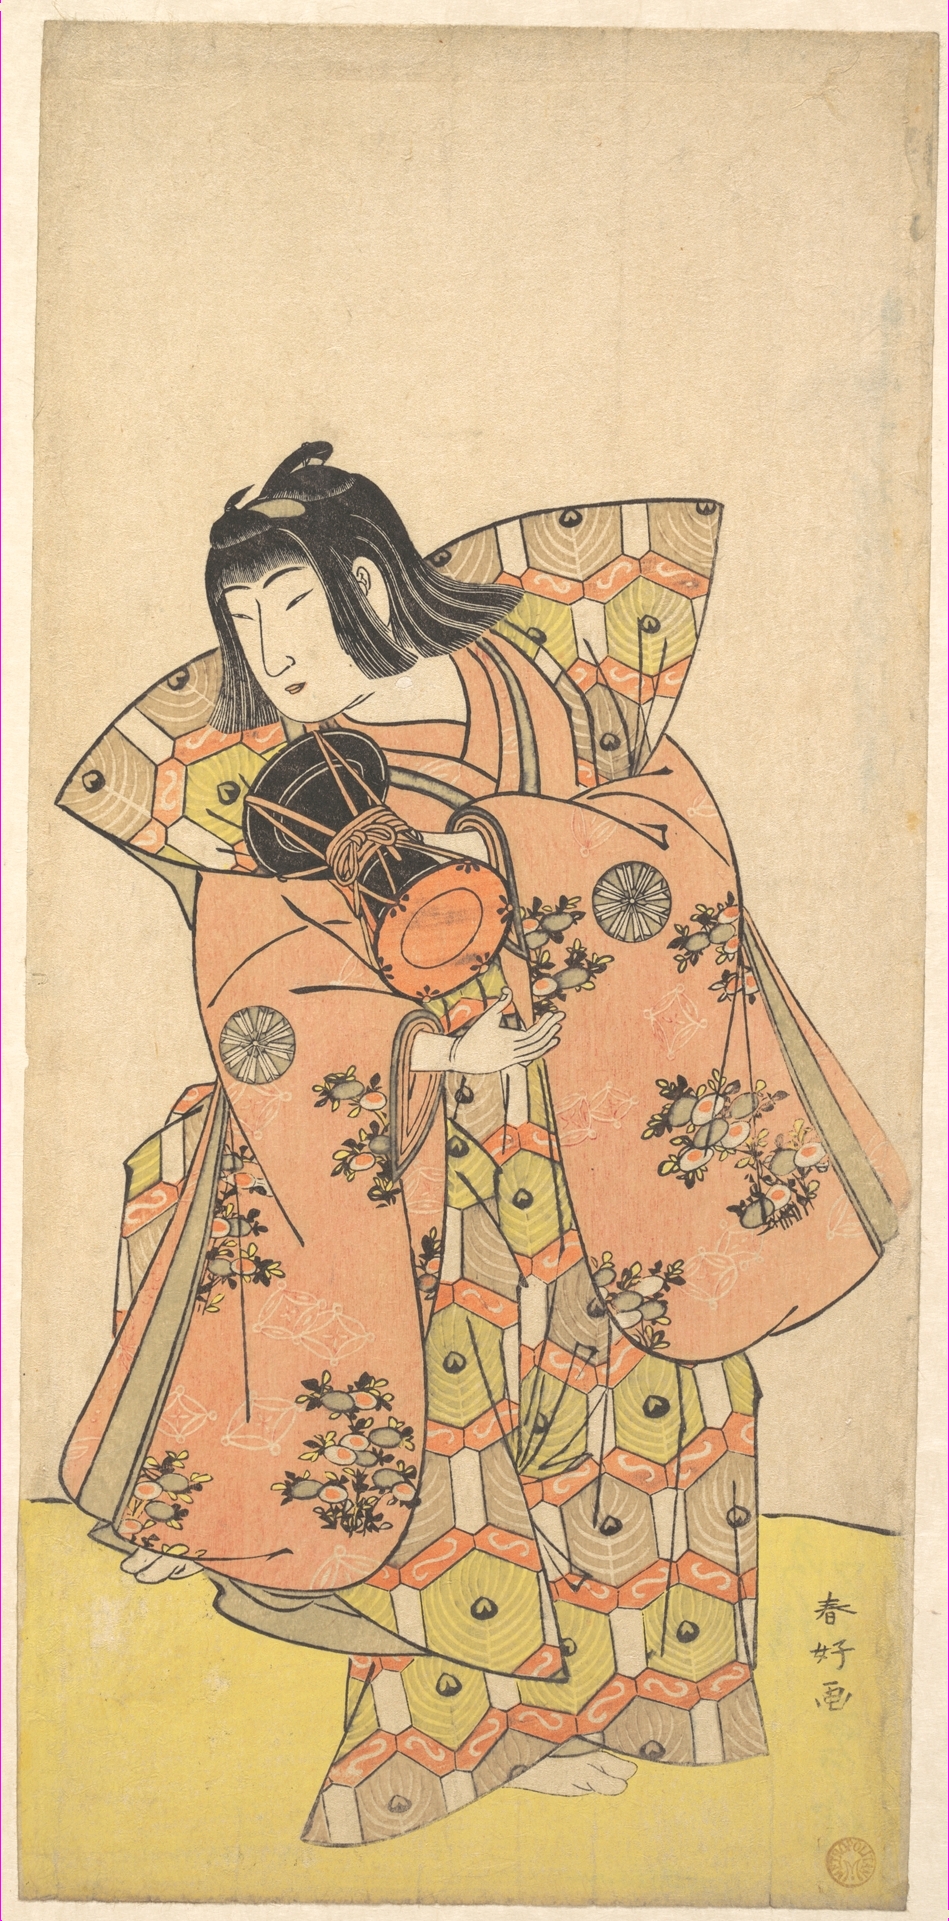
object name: woodblock print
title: The Actor Nakamura Tomijuro as Bijomaru in the Drama "Kikujido" Shuen no Iwaya"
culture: japanese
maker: katsukawa shunkō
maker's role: artist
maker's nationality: japanese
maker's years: 1743-1812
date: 1773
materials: ink, paper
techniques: woodblock print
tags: musical instruments,men,actors